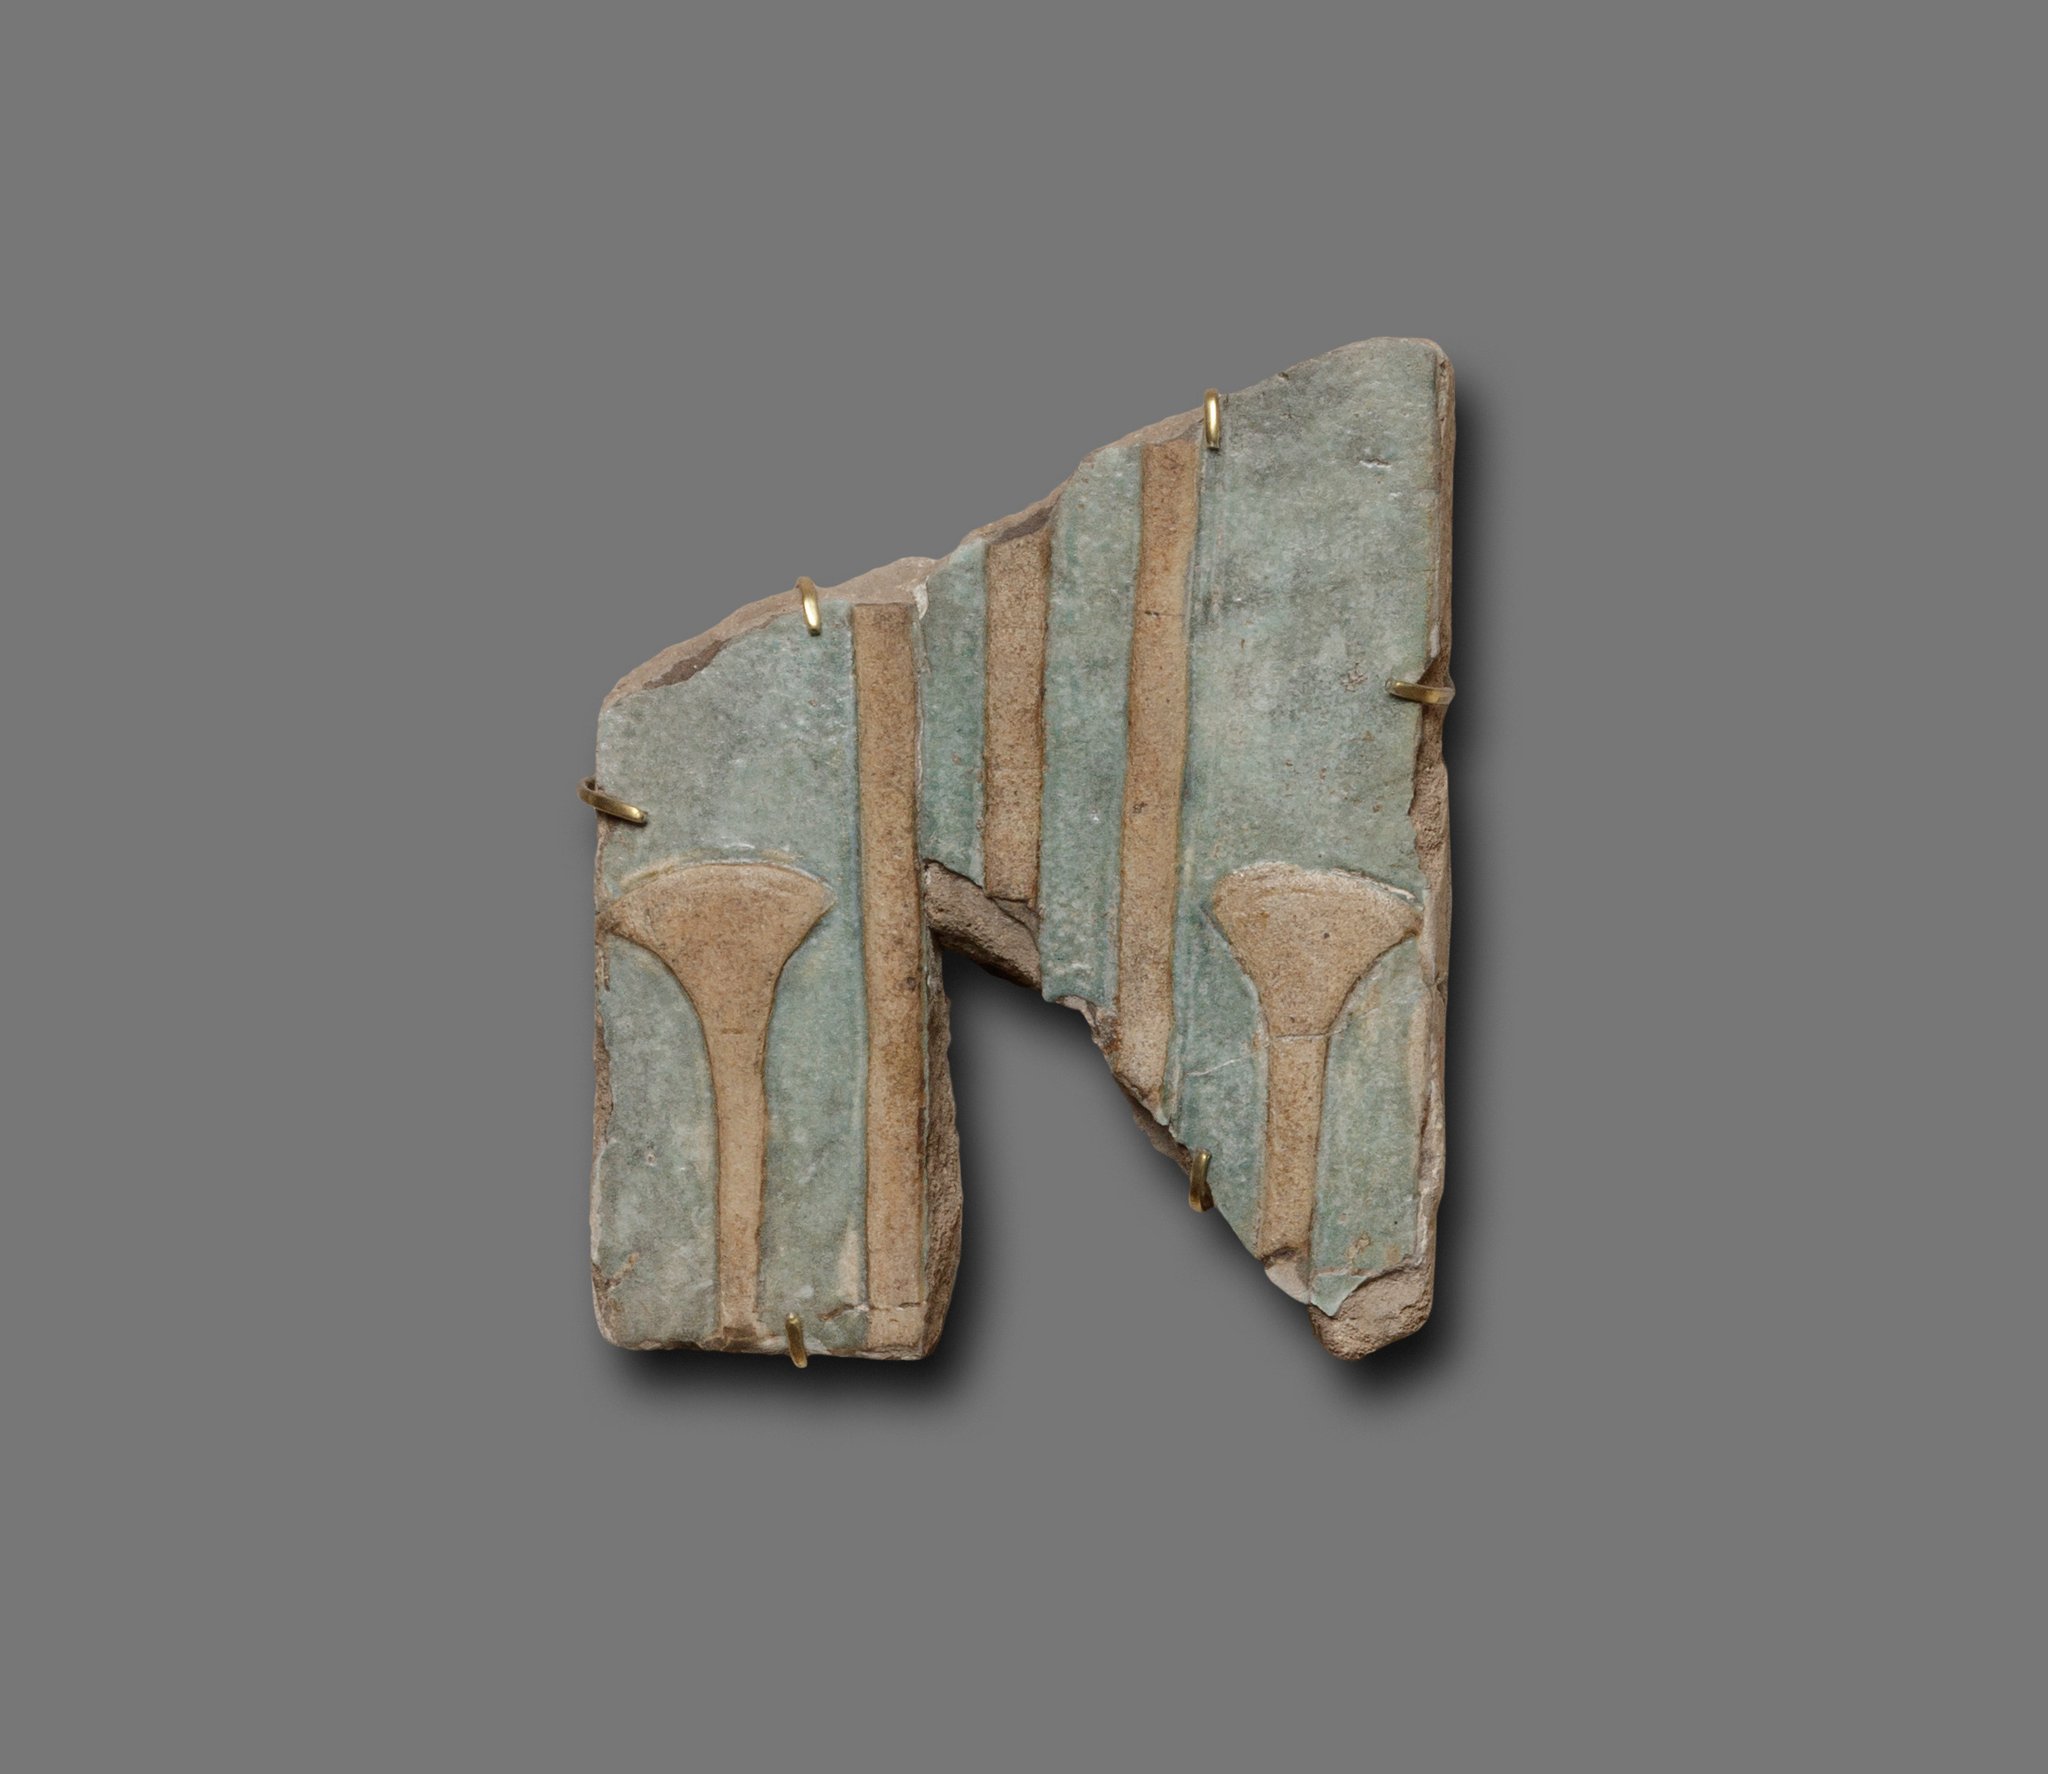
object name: tile, palace of ramesses ii, sedge and papyrus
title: Tile from the palace of Ramesses II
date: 1279-1213 BCE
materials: faience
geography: egypt